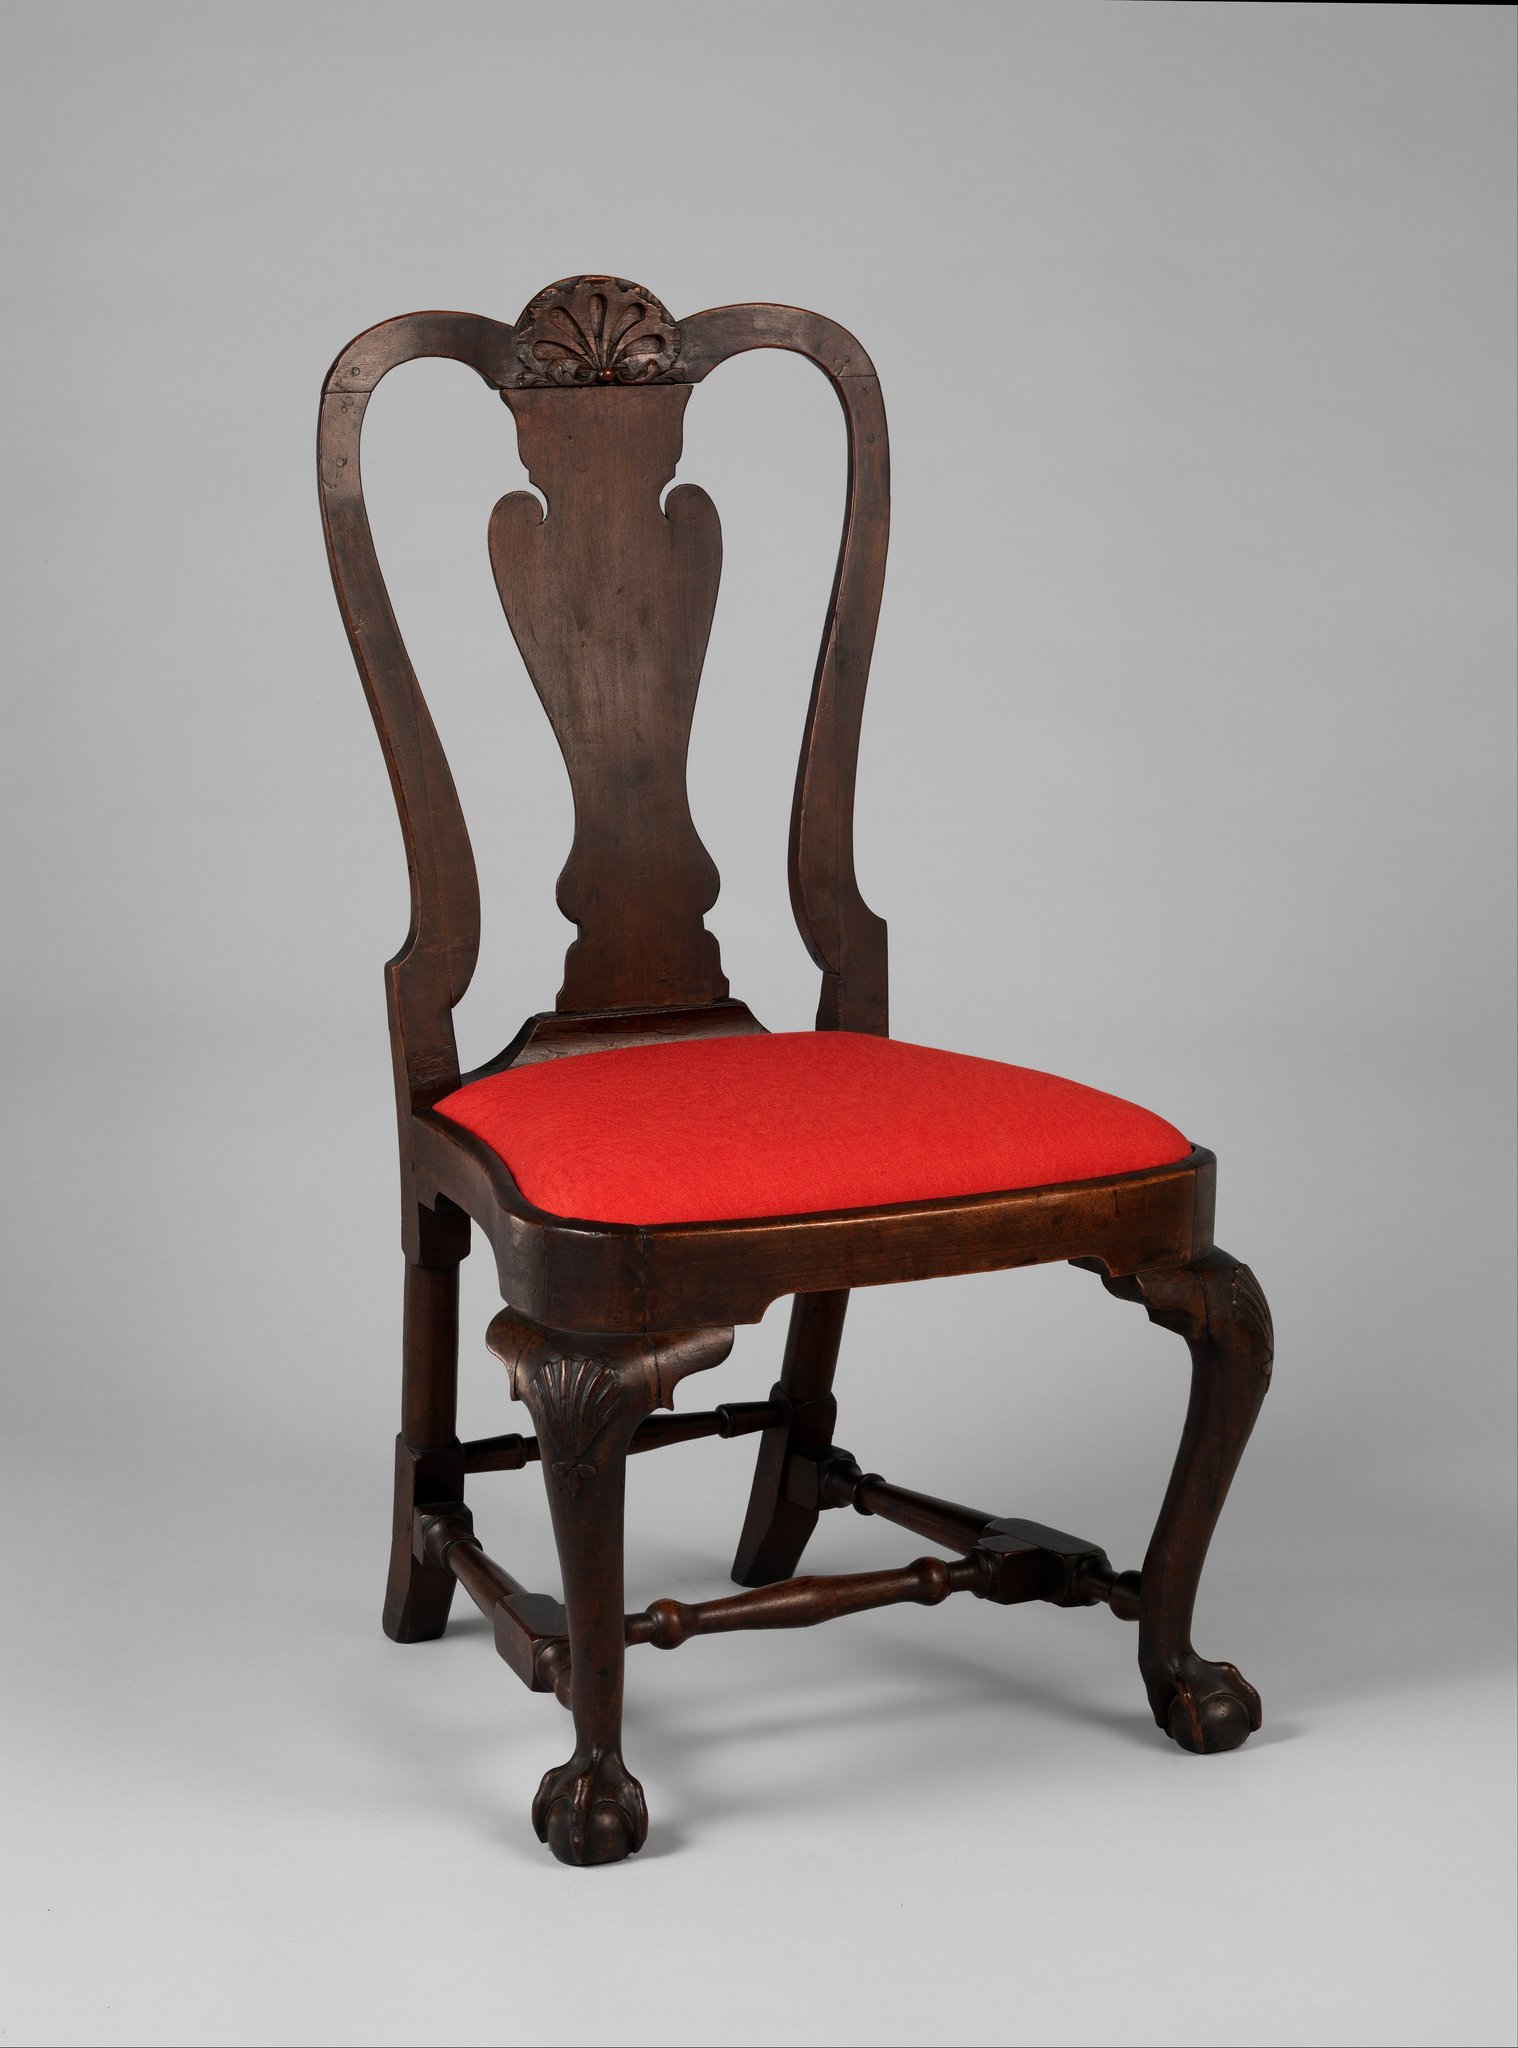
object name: side chair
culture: american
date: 1740-1790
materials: wood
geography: united states